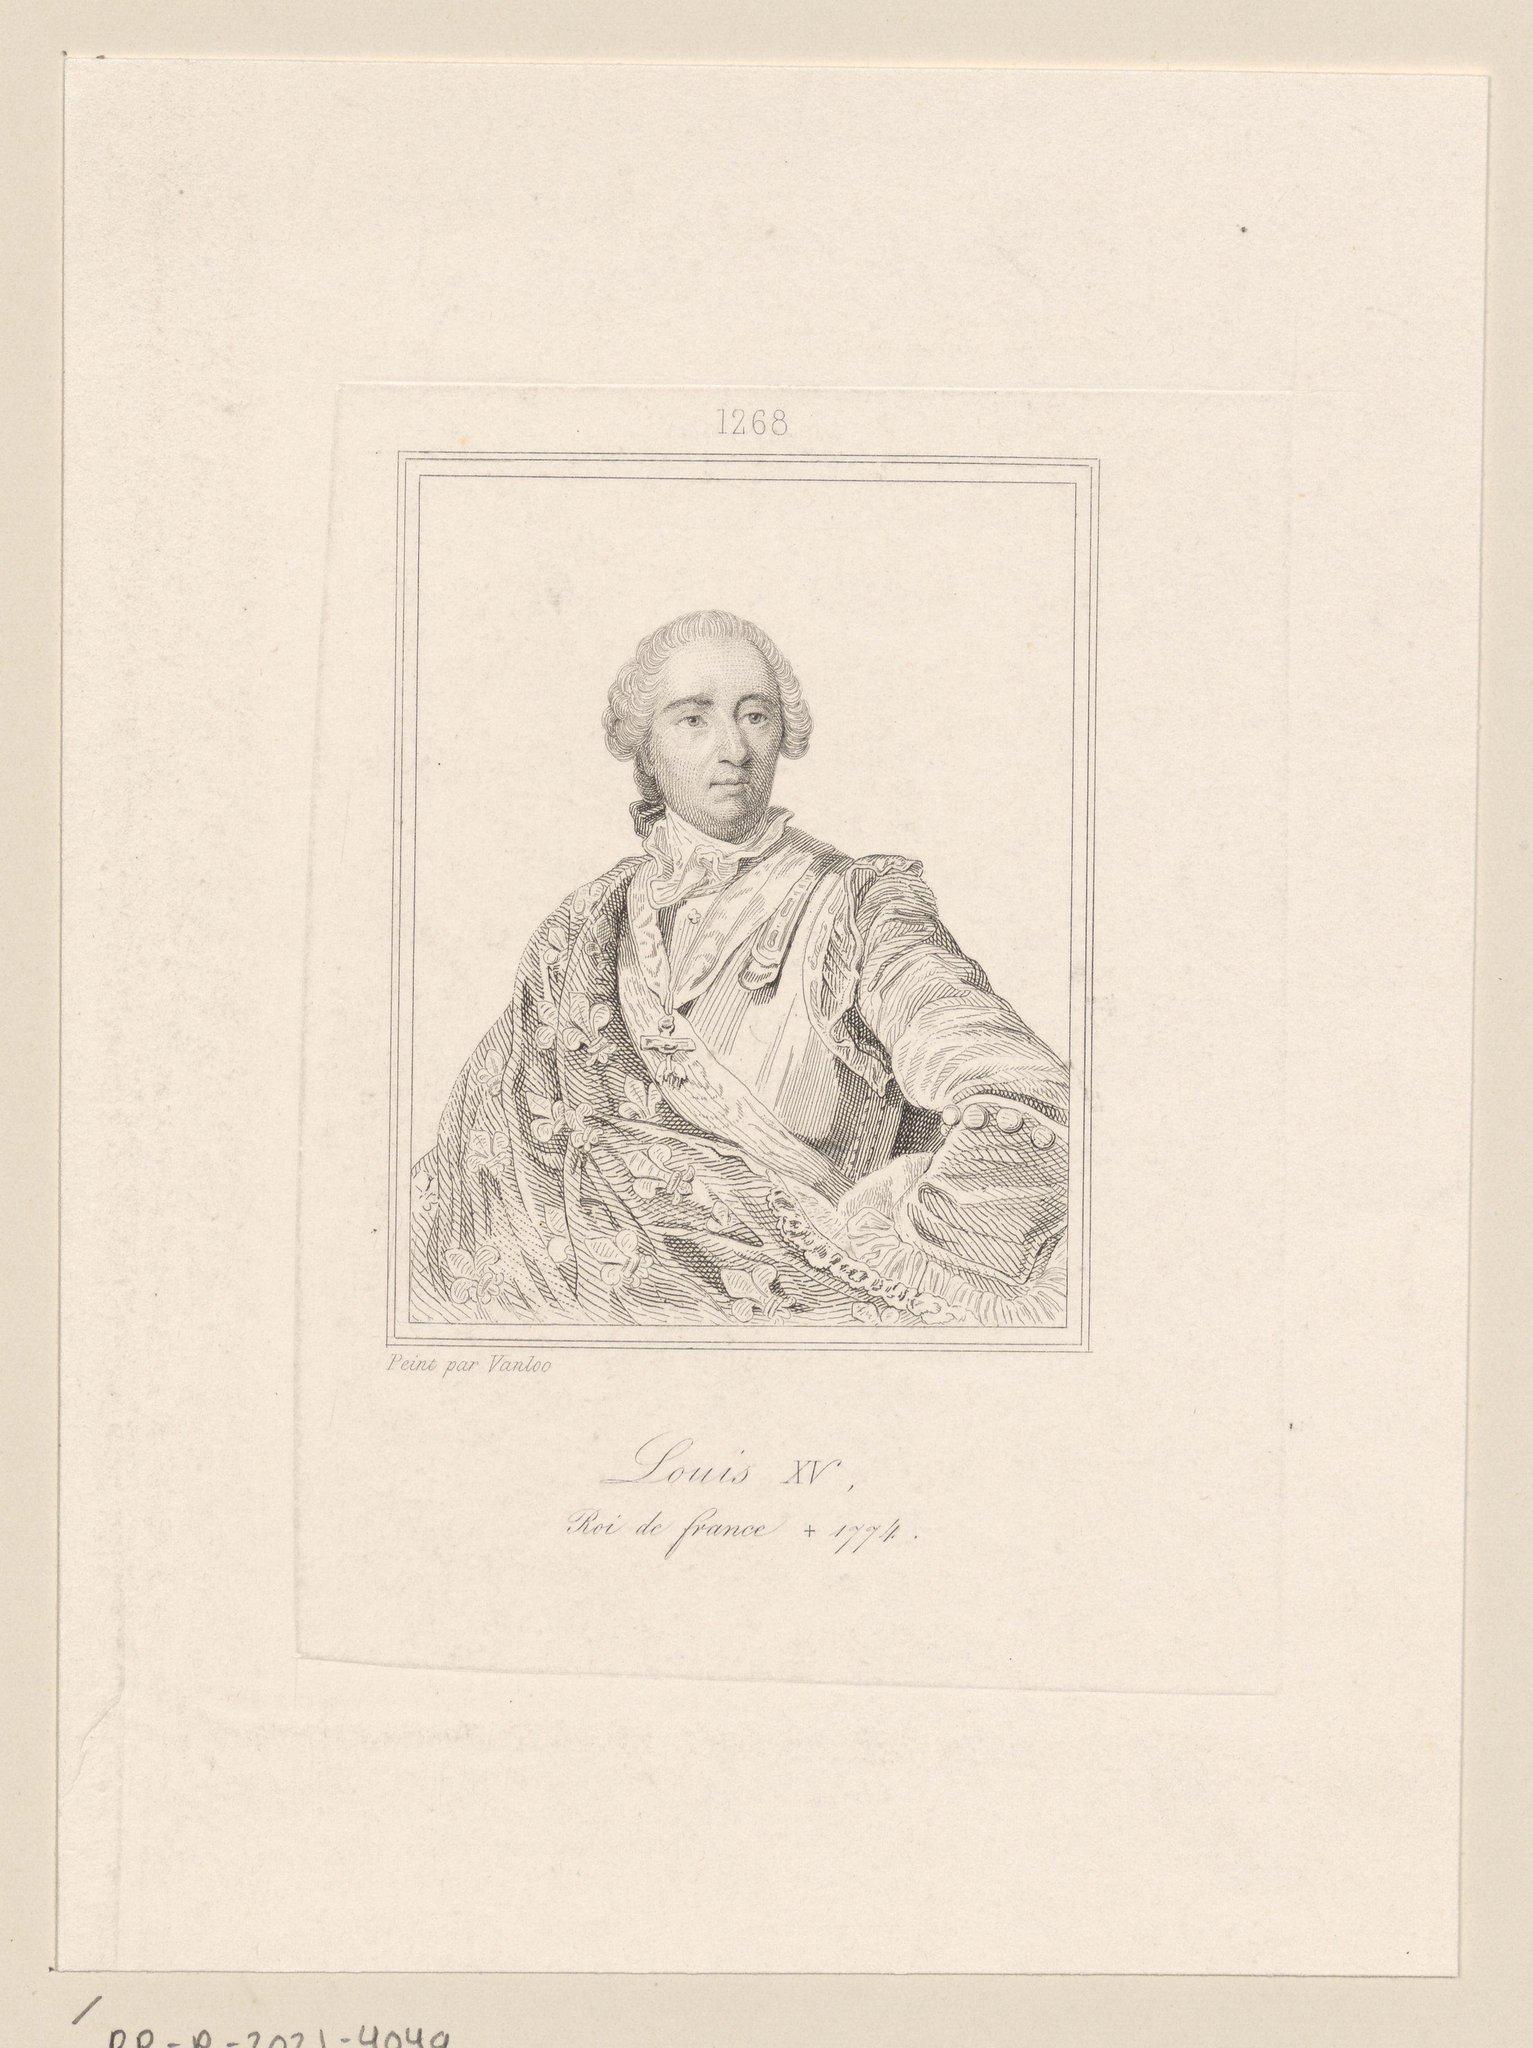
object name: print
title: Galeries historiques de Versailles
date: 1839-1848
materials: paper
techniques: etching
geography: france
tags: louis xv of france, historical persons, knighthood order of the golden fleece - insignia of a knighthood order, e.g.: badge, chain (with name of order), king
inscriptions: inscription: ‘[...] Do f no/ 4/12/47’